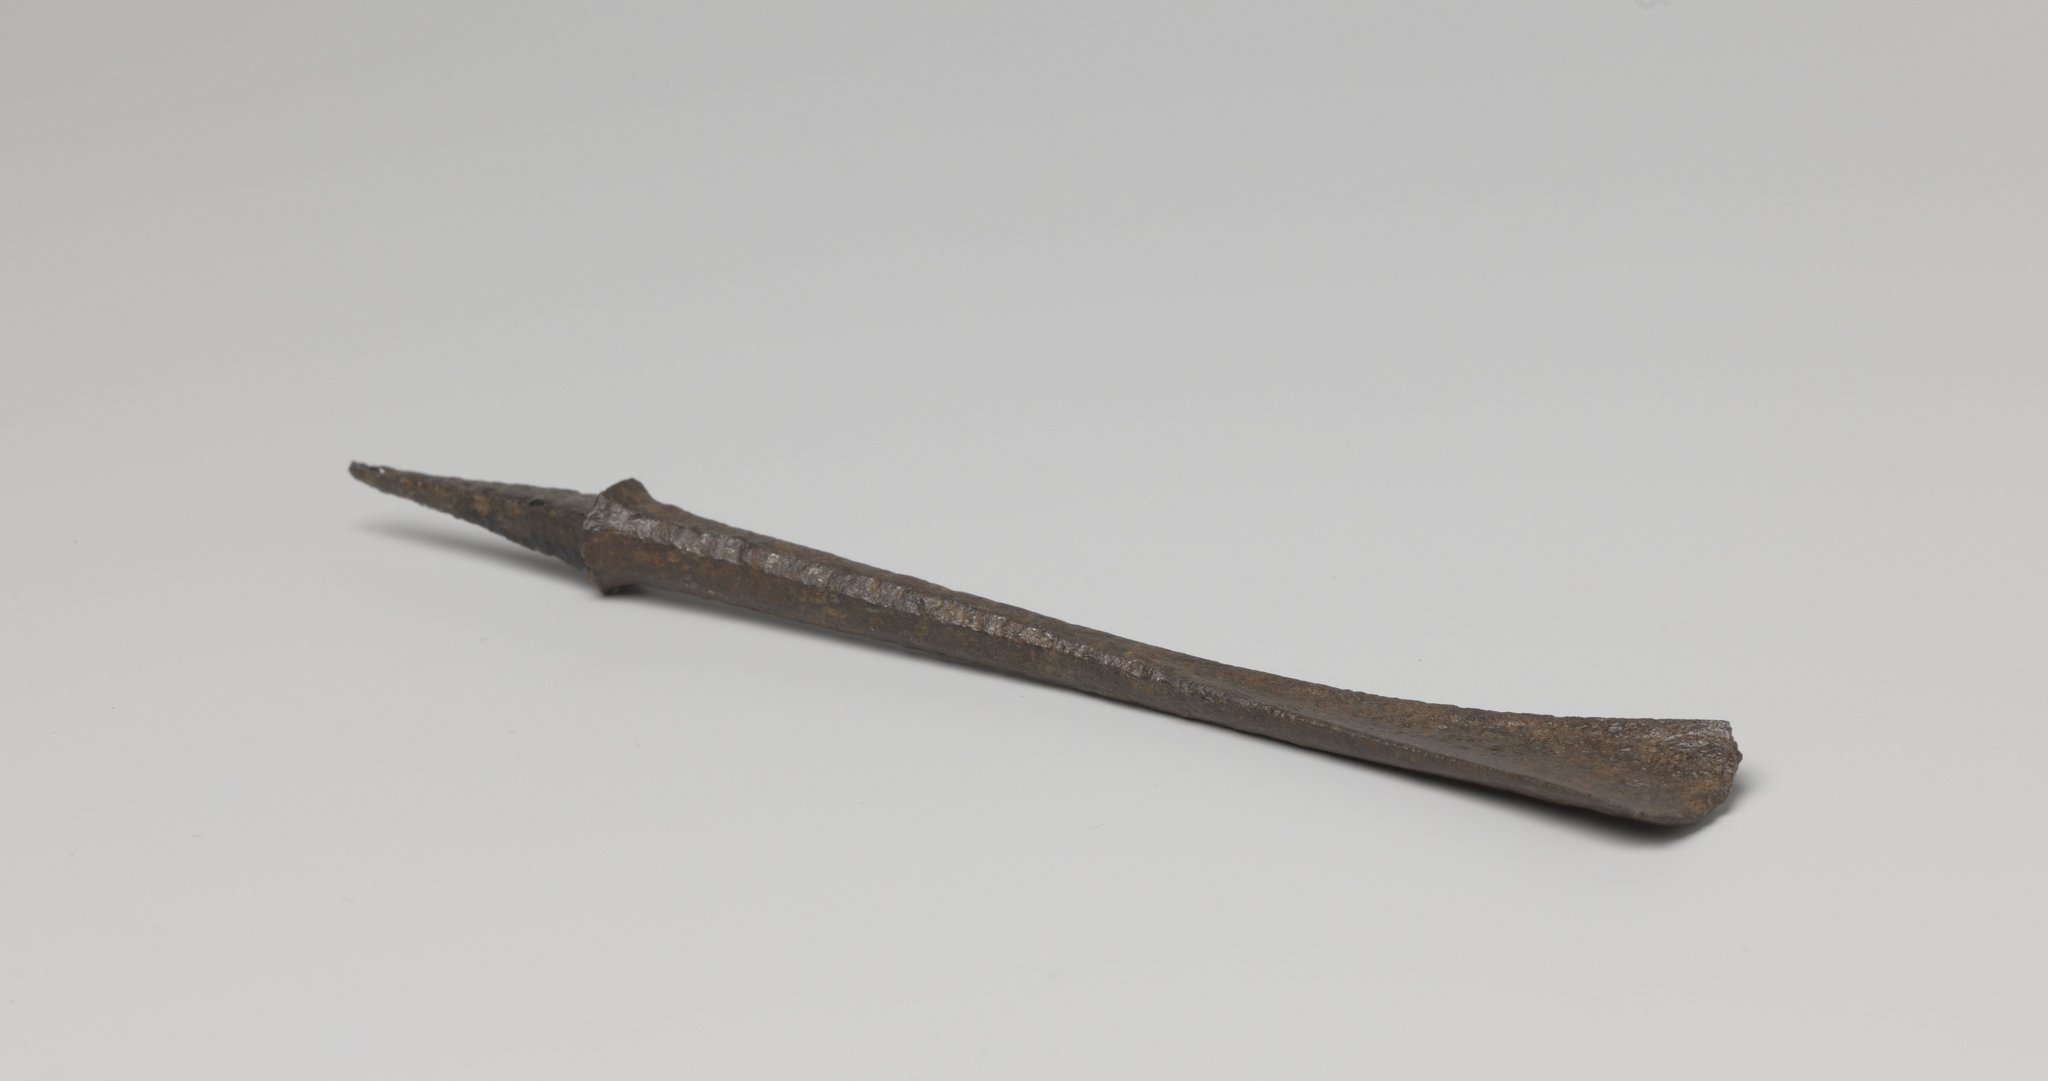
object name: gouge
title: Guts of holle beitel met schuin uitlopende snede waarvan de beitel voorzien is van een randlijst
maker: Anonymous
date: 1590-1596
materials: iron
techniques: forging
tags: willem barendsz., amsterdam, jacob van heemskerck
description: Gouges or hollow chisels